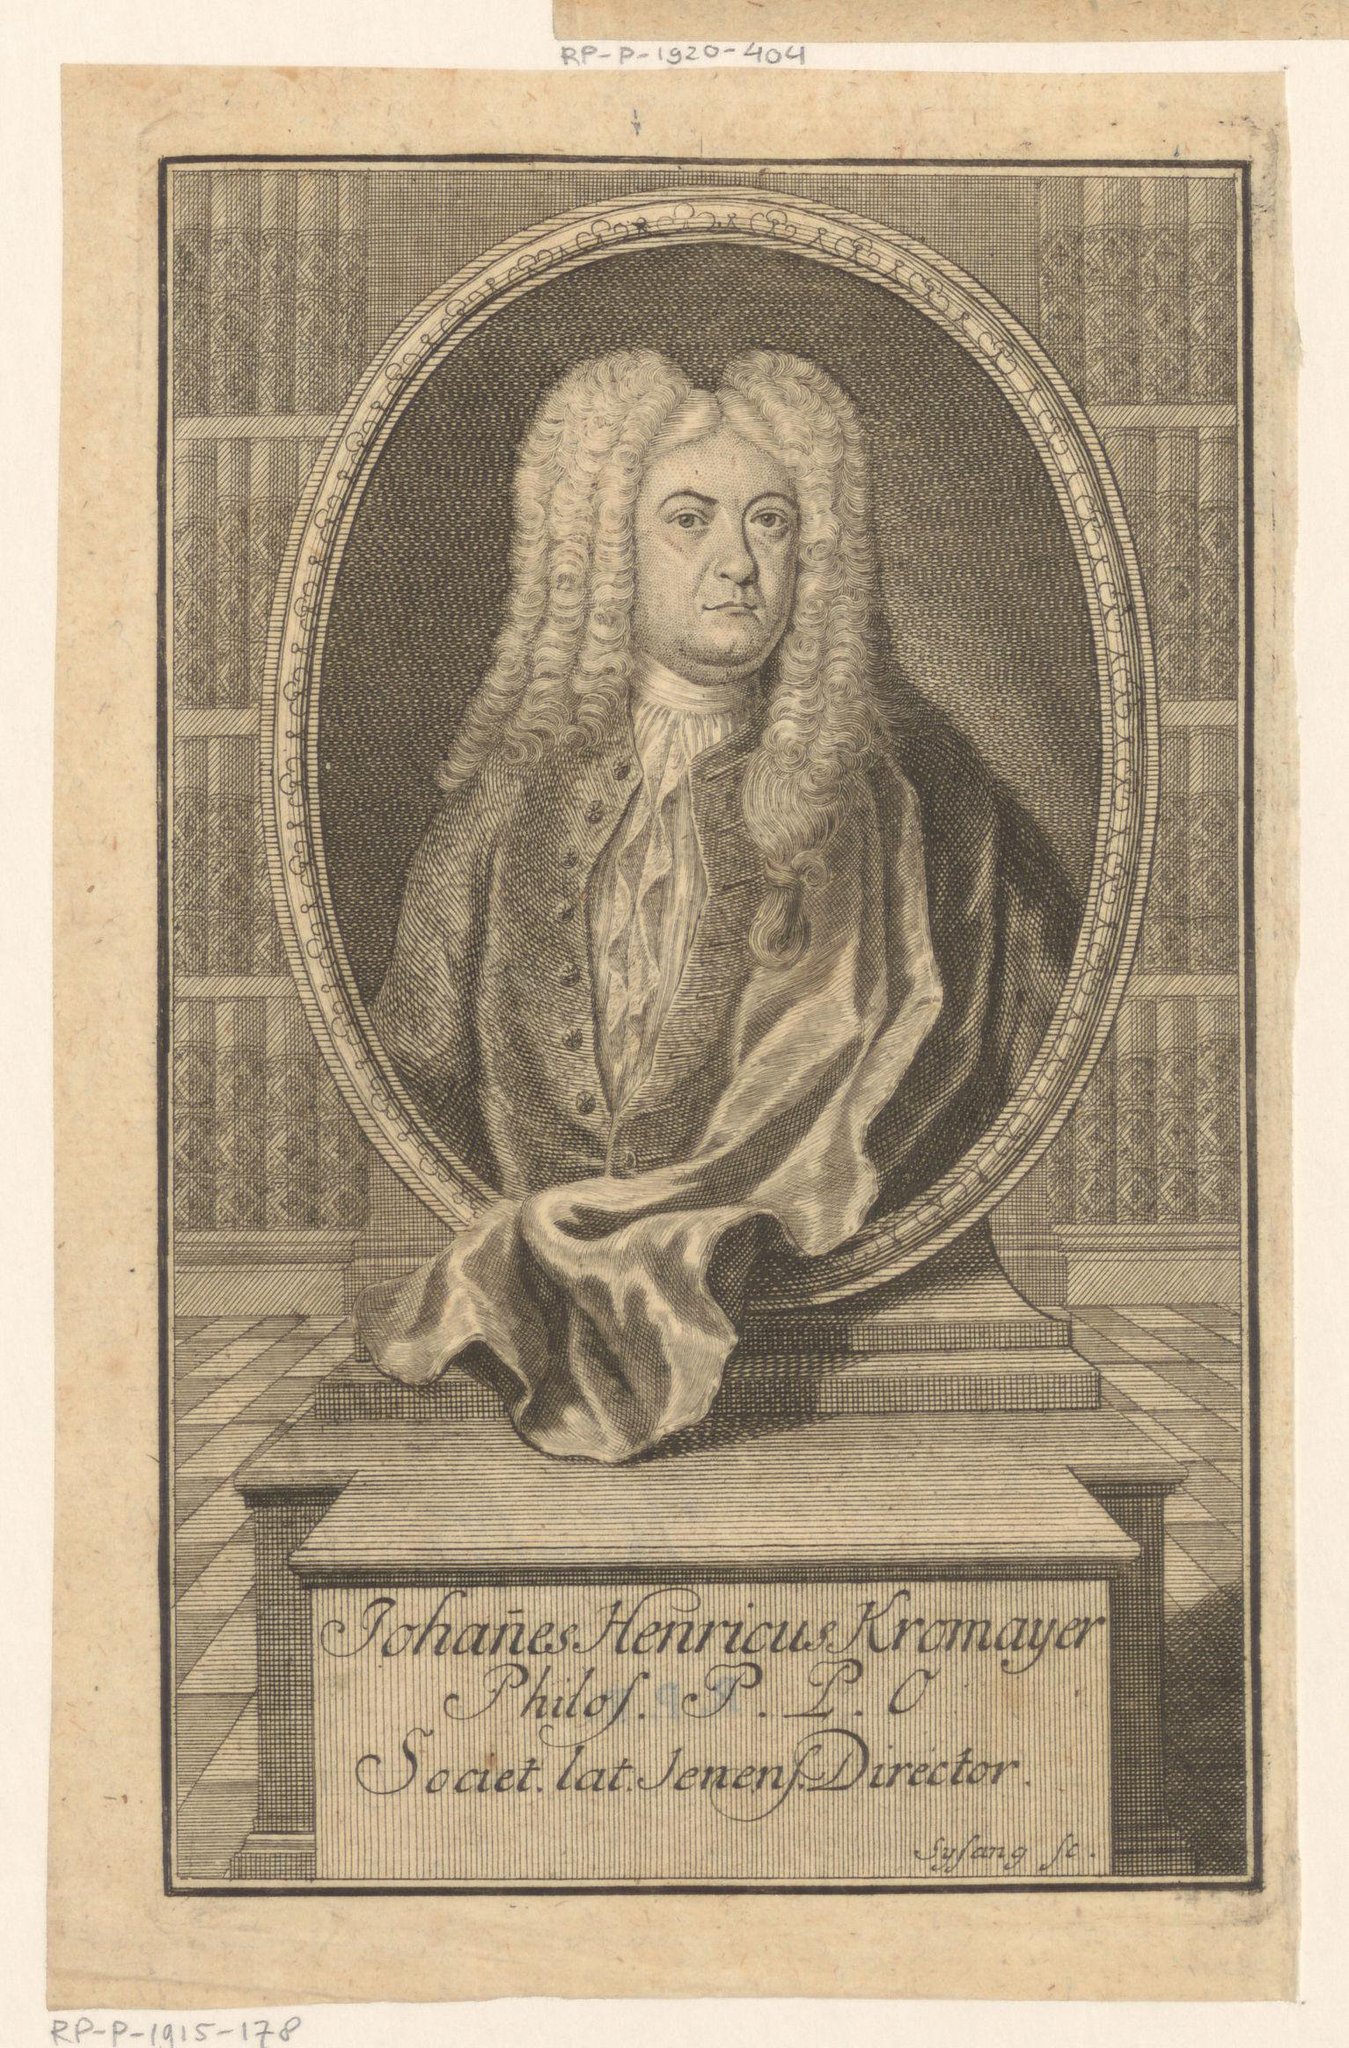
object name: print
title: Portret van Johann Heinrich Kromayer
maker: johann christoph sysang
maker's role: print maker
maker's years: 1703-1757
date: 1731-1757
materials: paper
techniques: engraving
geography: germany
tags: bookshelves, historical persons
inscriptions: collector's mark: Lugt 2233